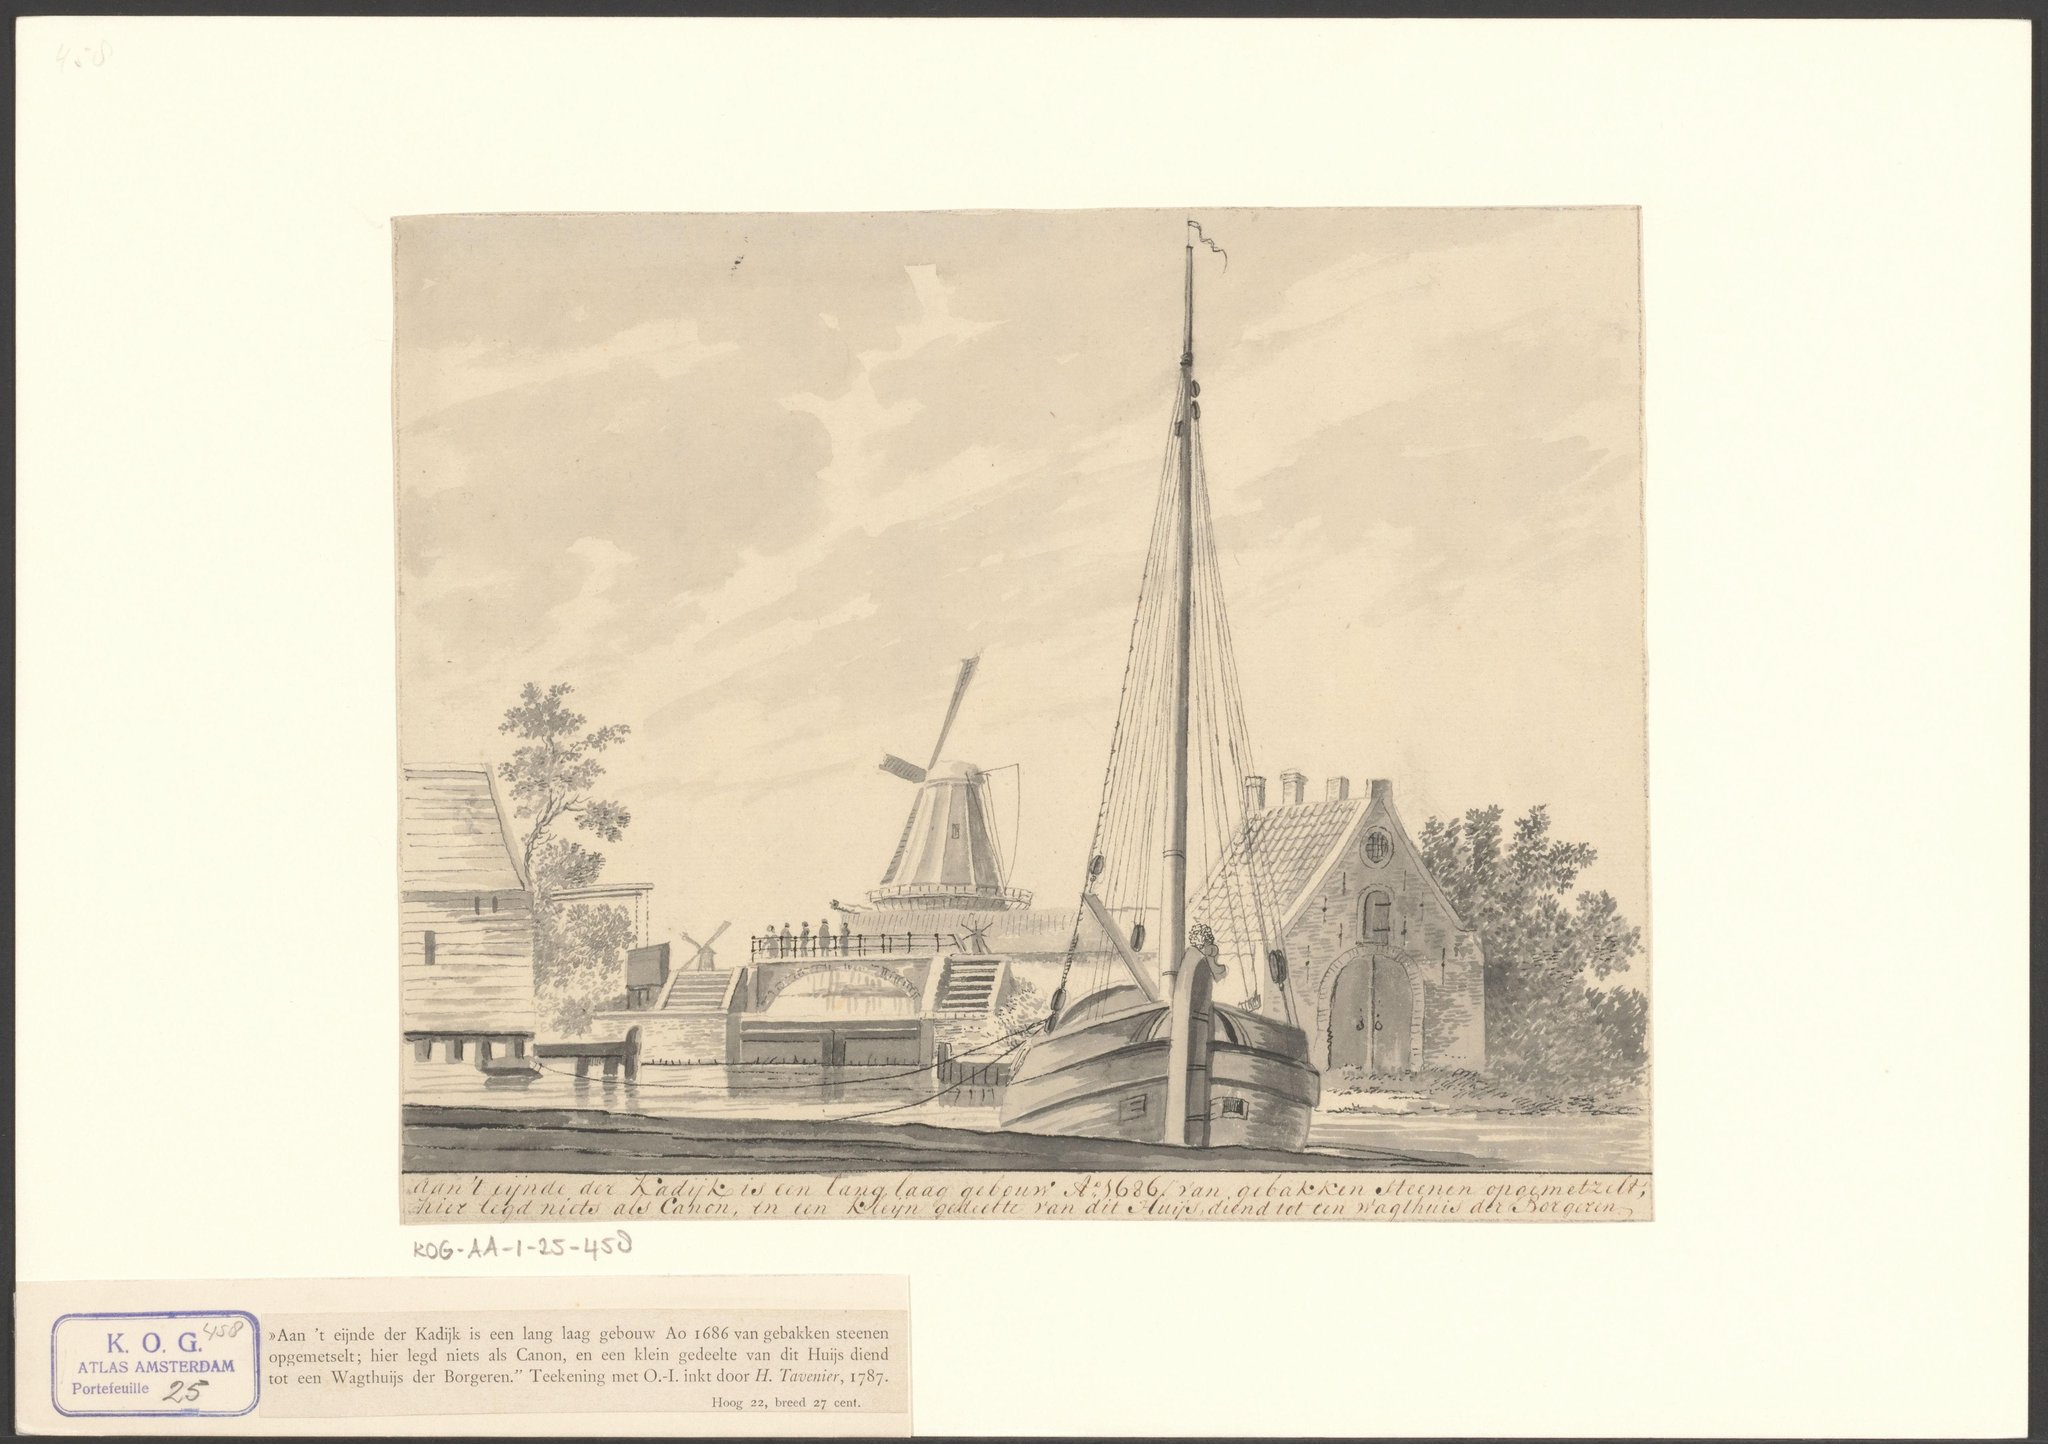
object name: drawing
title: Gezicht op een wachthuis bij de Kadijk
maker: hendrik tavenier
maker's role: draughtsman, print maker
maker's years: 1734-1807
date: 1785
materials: ink, paper, pencil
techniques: brush, pen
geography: amsterdam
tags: sluice, weir, city-view in general; 'veduta', canal, windmill in landscape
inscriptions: inscription: ‘aan 't eijnde (...) Wagthuijs der Borgeren.’, inscription: ‘Aan het eijnde (...) breed 27 cent.’, inscription: ‘Port. 25-458’, collector's mark: ‘25’ Lugt 1641b, signature and date: ‘H: Tavenier fecit 1785’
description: Onderwerpsrubriek binnen de Atlas Amsterdam: Doelen en Wachthuizen.